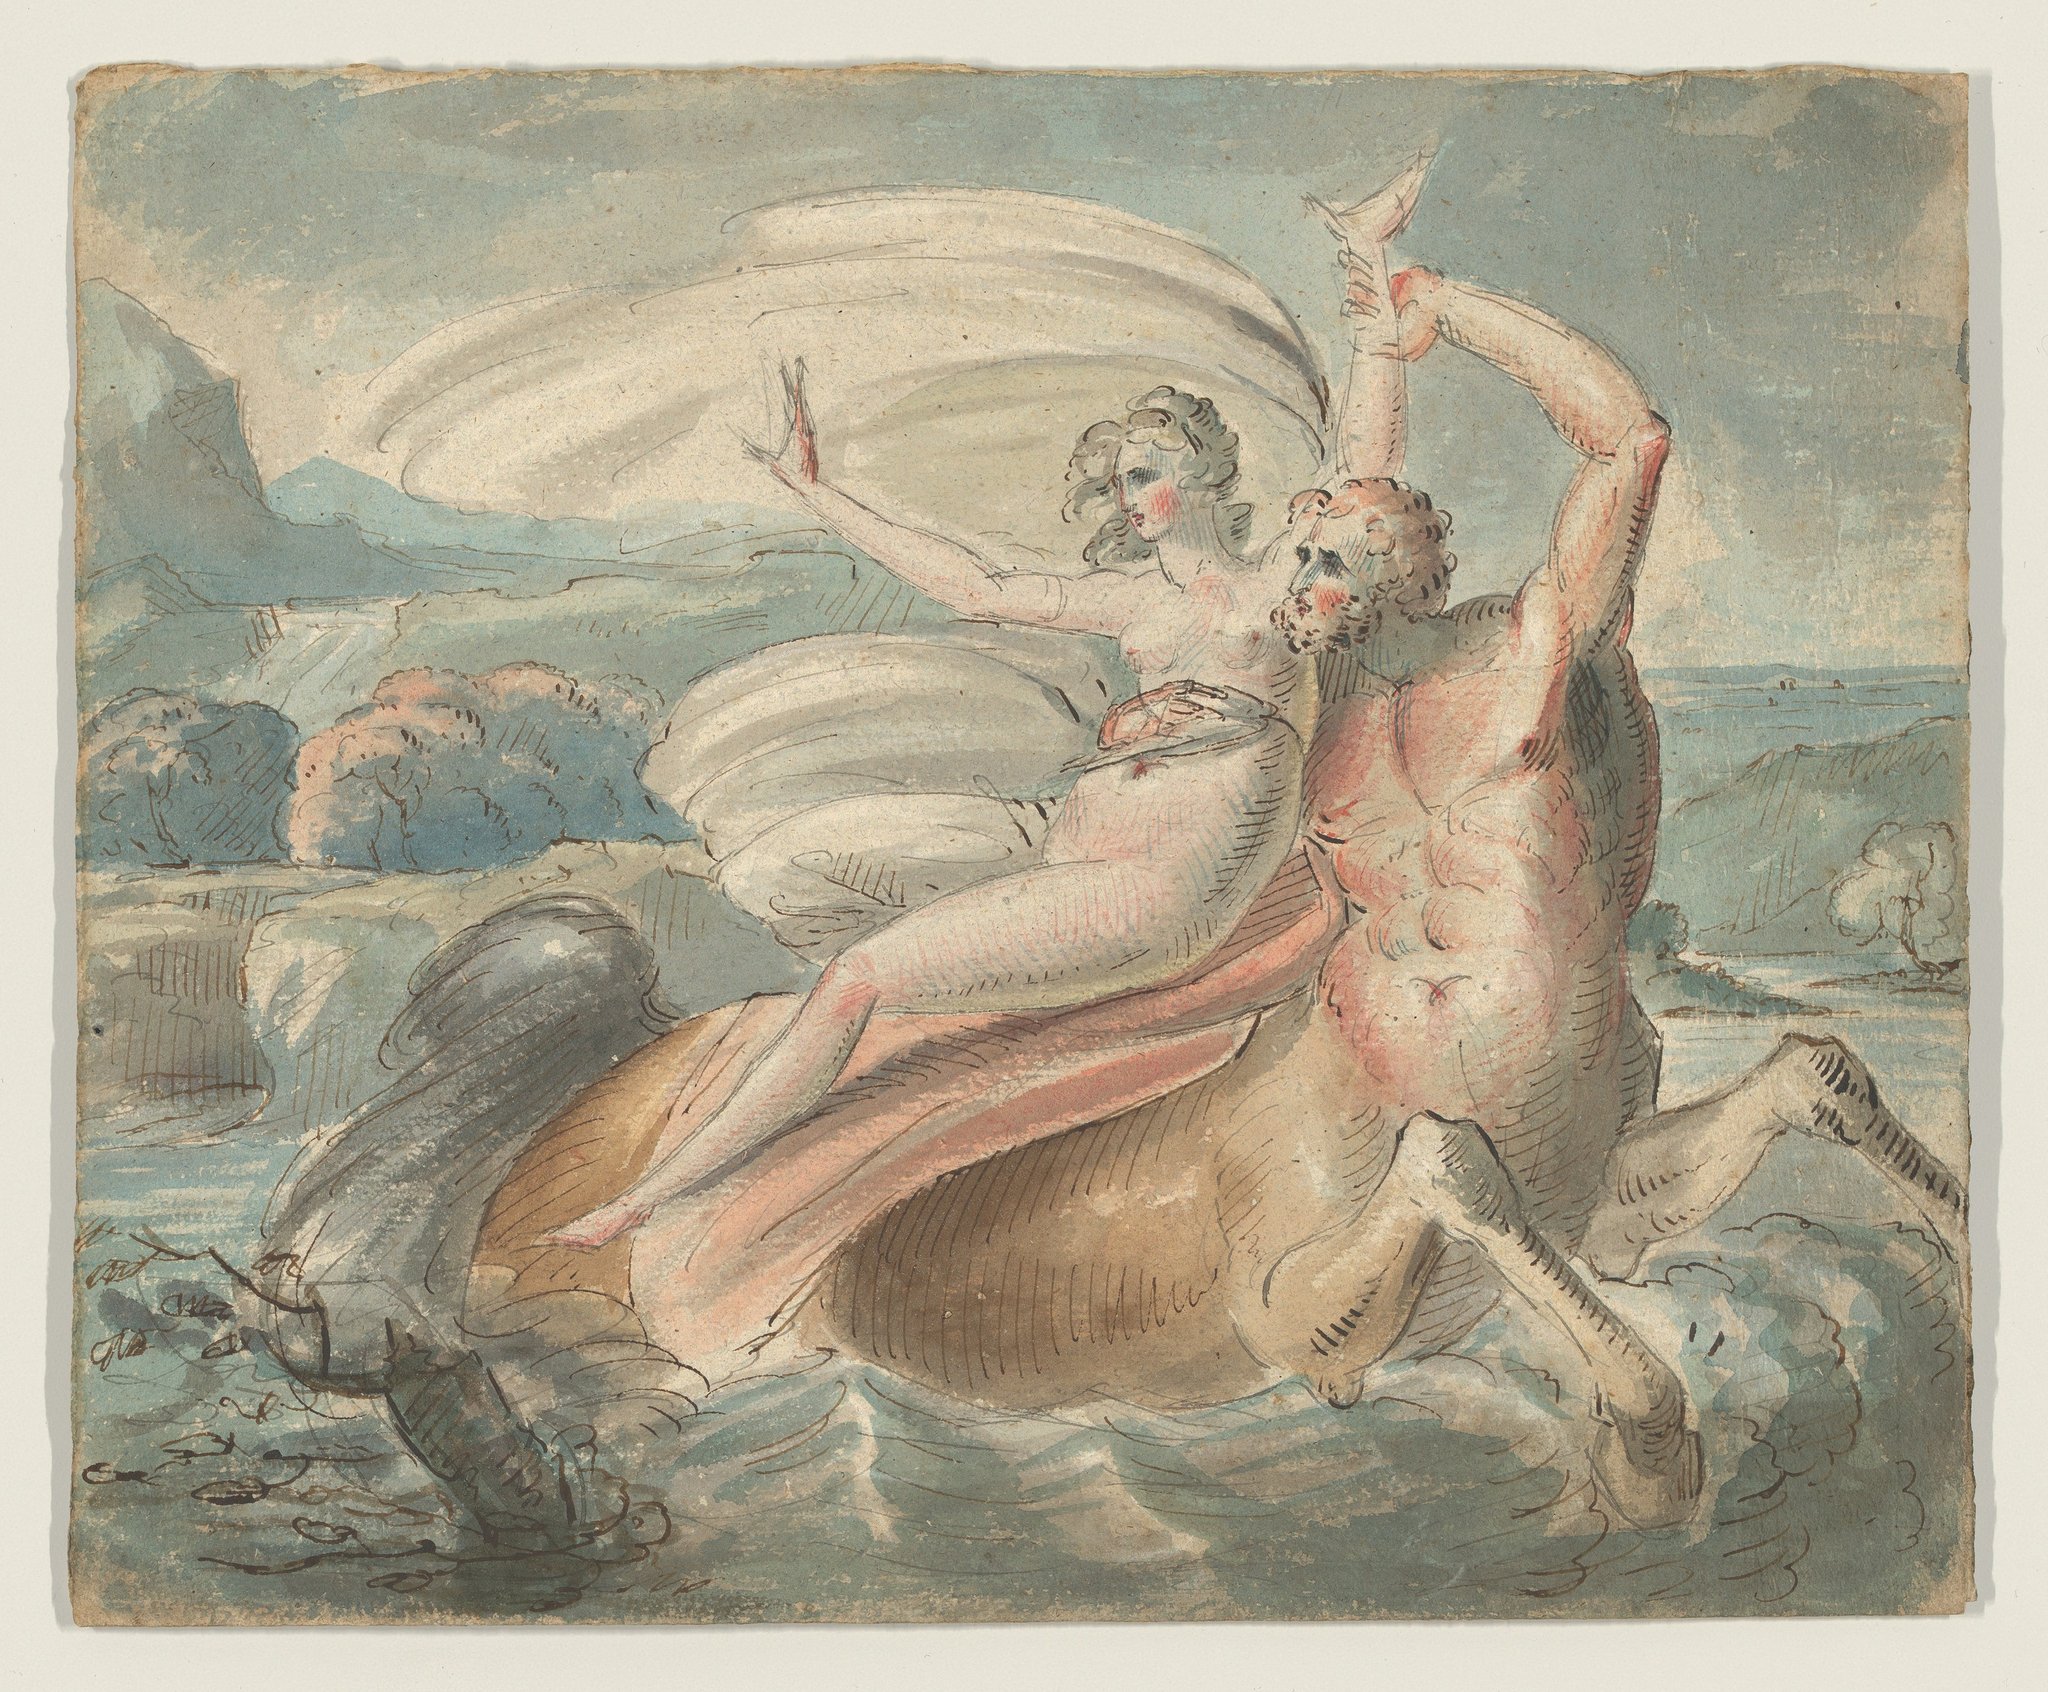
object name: drawing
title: The Abduction of Deianira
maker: william hamilton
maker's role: artist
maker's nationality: british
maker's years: 1751-1801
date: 1770-1780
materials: graphite, ink, watercolor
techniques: pen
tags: female nudes,centaurs